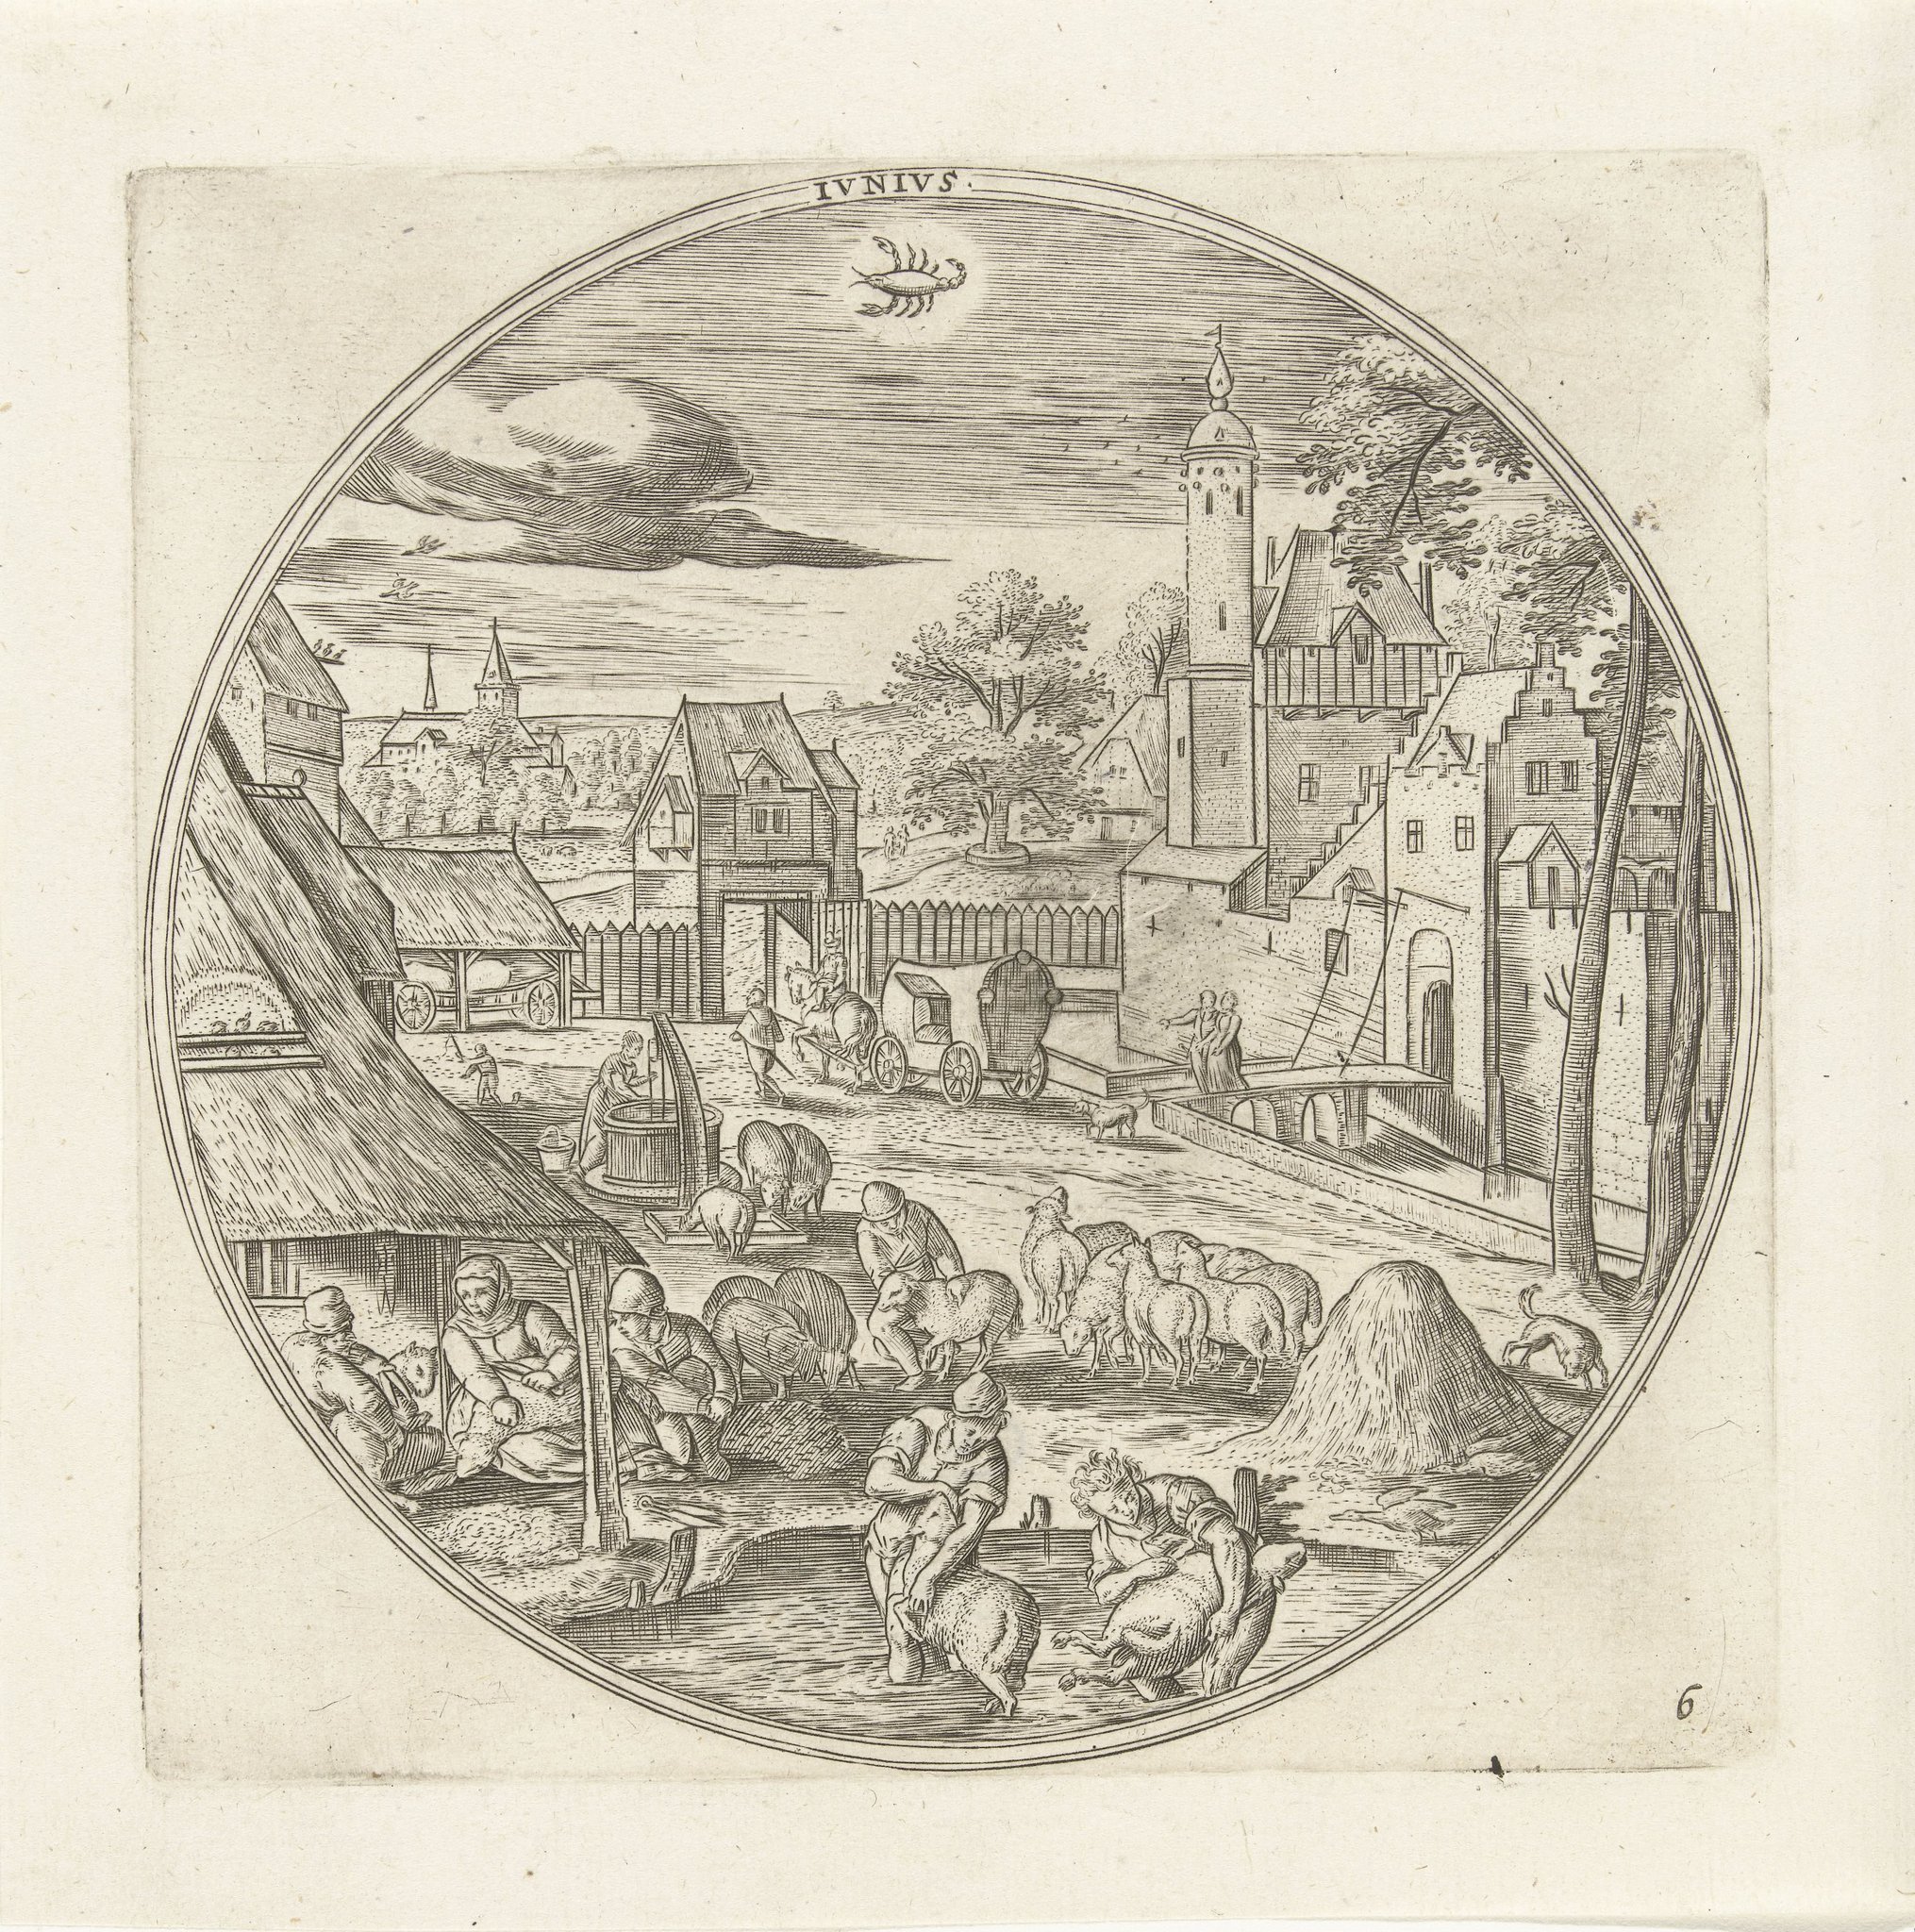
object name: print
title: Juni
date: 1578-1582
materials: paper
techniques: engraving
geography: antwerp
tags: dipping, washing (sheep or other animals), june and its 'labours' (+ with zodiacal signs), shearing (sheep)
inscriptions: collector's mark: Lugt 2228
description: Ronde lijst met een stadsgezicht met zomertaferelen.Juni is de scheermaand. Centraal staat het wassen en scheren van de schapen en het sorteren van hun wol. Middenboven het sterrenbeeld Kreeft. De prent is deel van een twaalfdelige serie over de twaalf maanden.